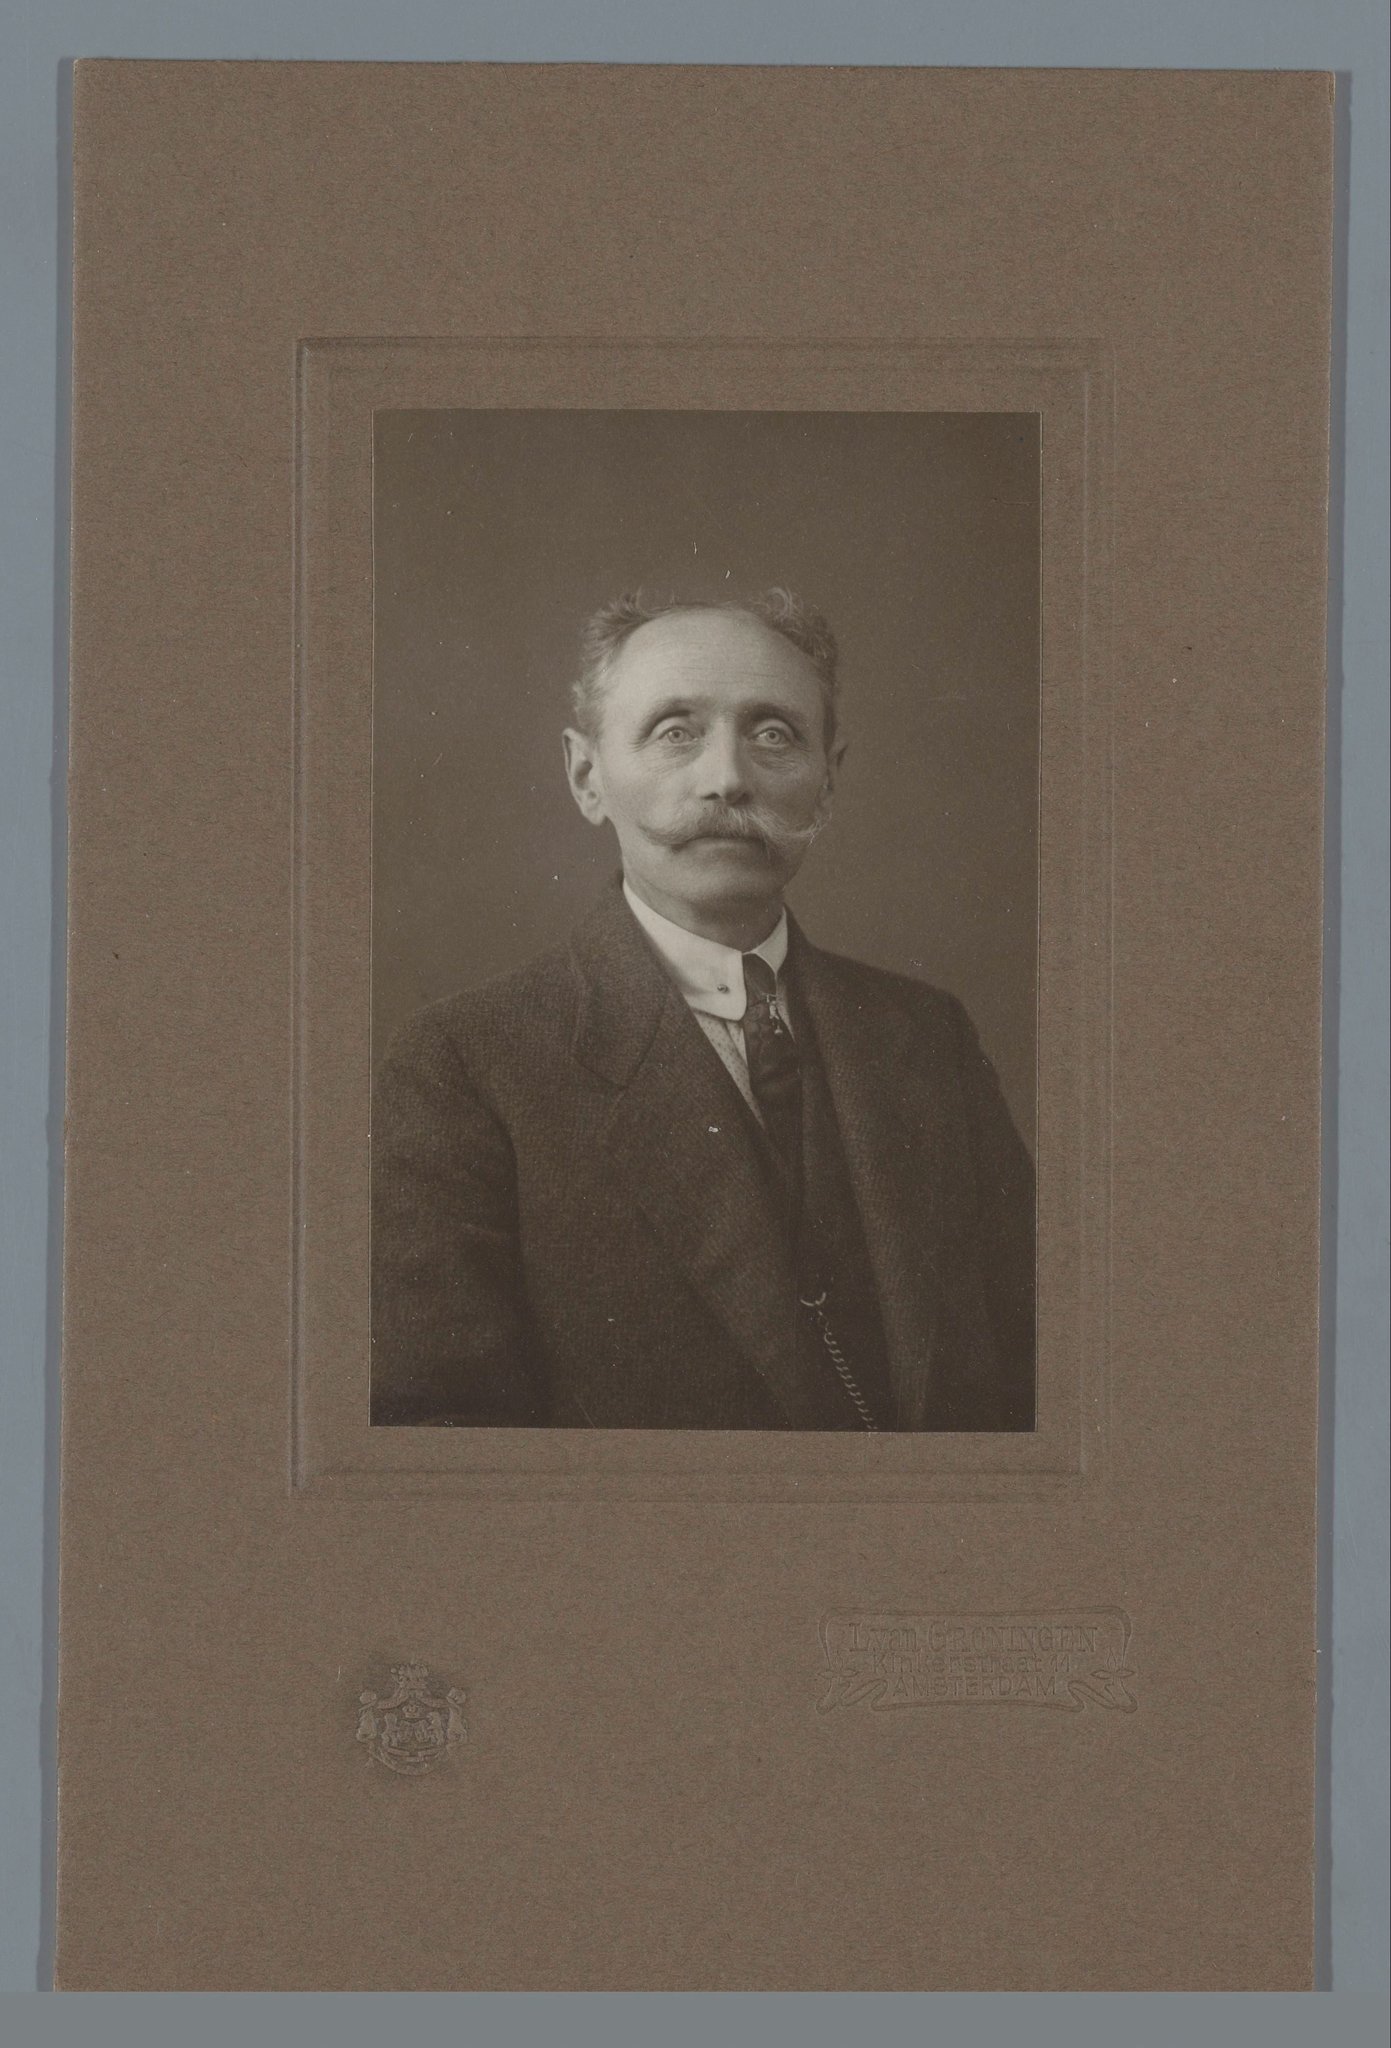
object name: cabinet photograph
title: Portret van een onbekende man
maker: laurus van groningen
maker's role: fotograaf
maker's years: 1871-1965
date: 1880-1920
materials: cardboard, photographic support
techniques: gelatin silver print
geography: amsterdam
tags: adult man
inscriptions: name: ‘L. van Groningen Kinkerstraat 11 Amsterdam’, number: ‘fam de [...] 30278’